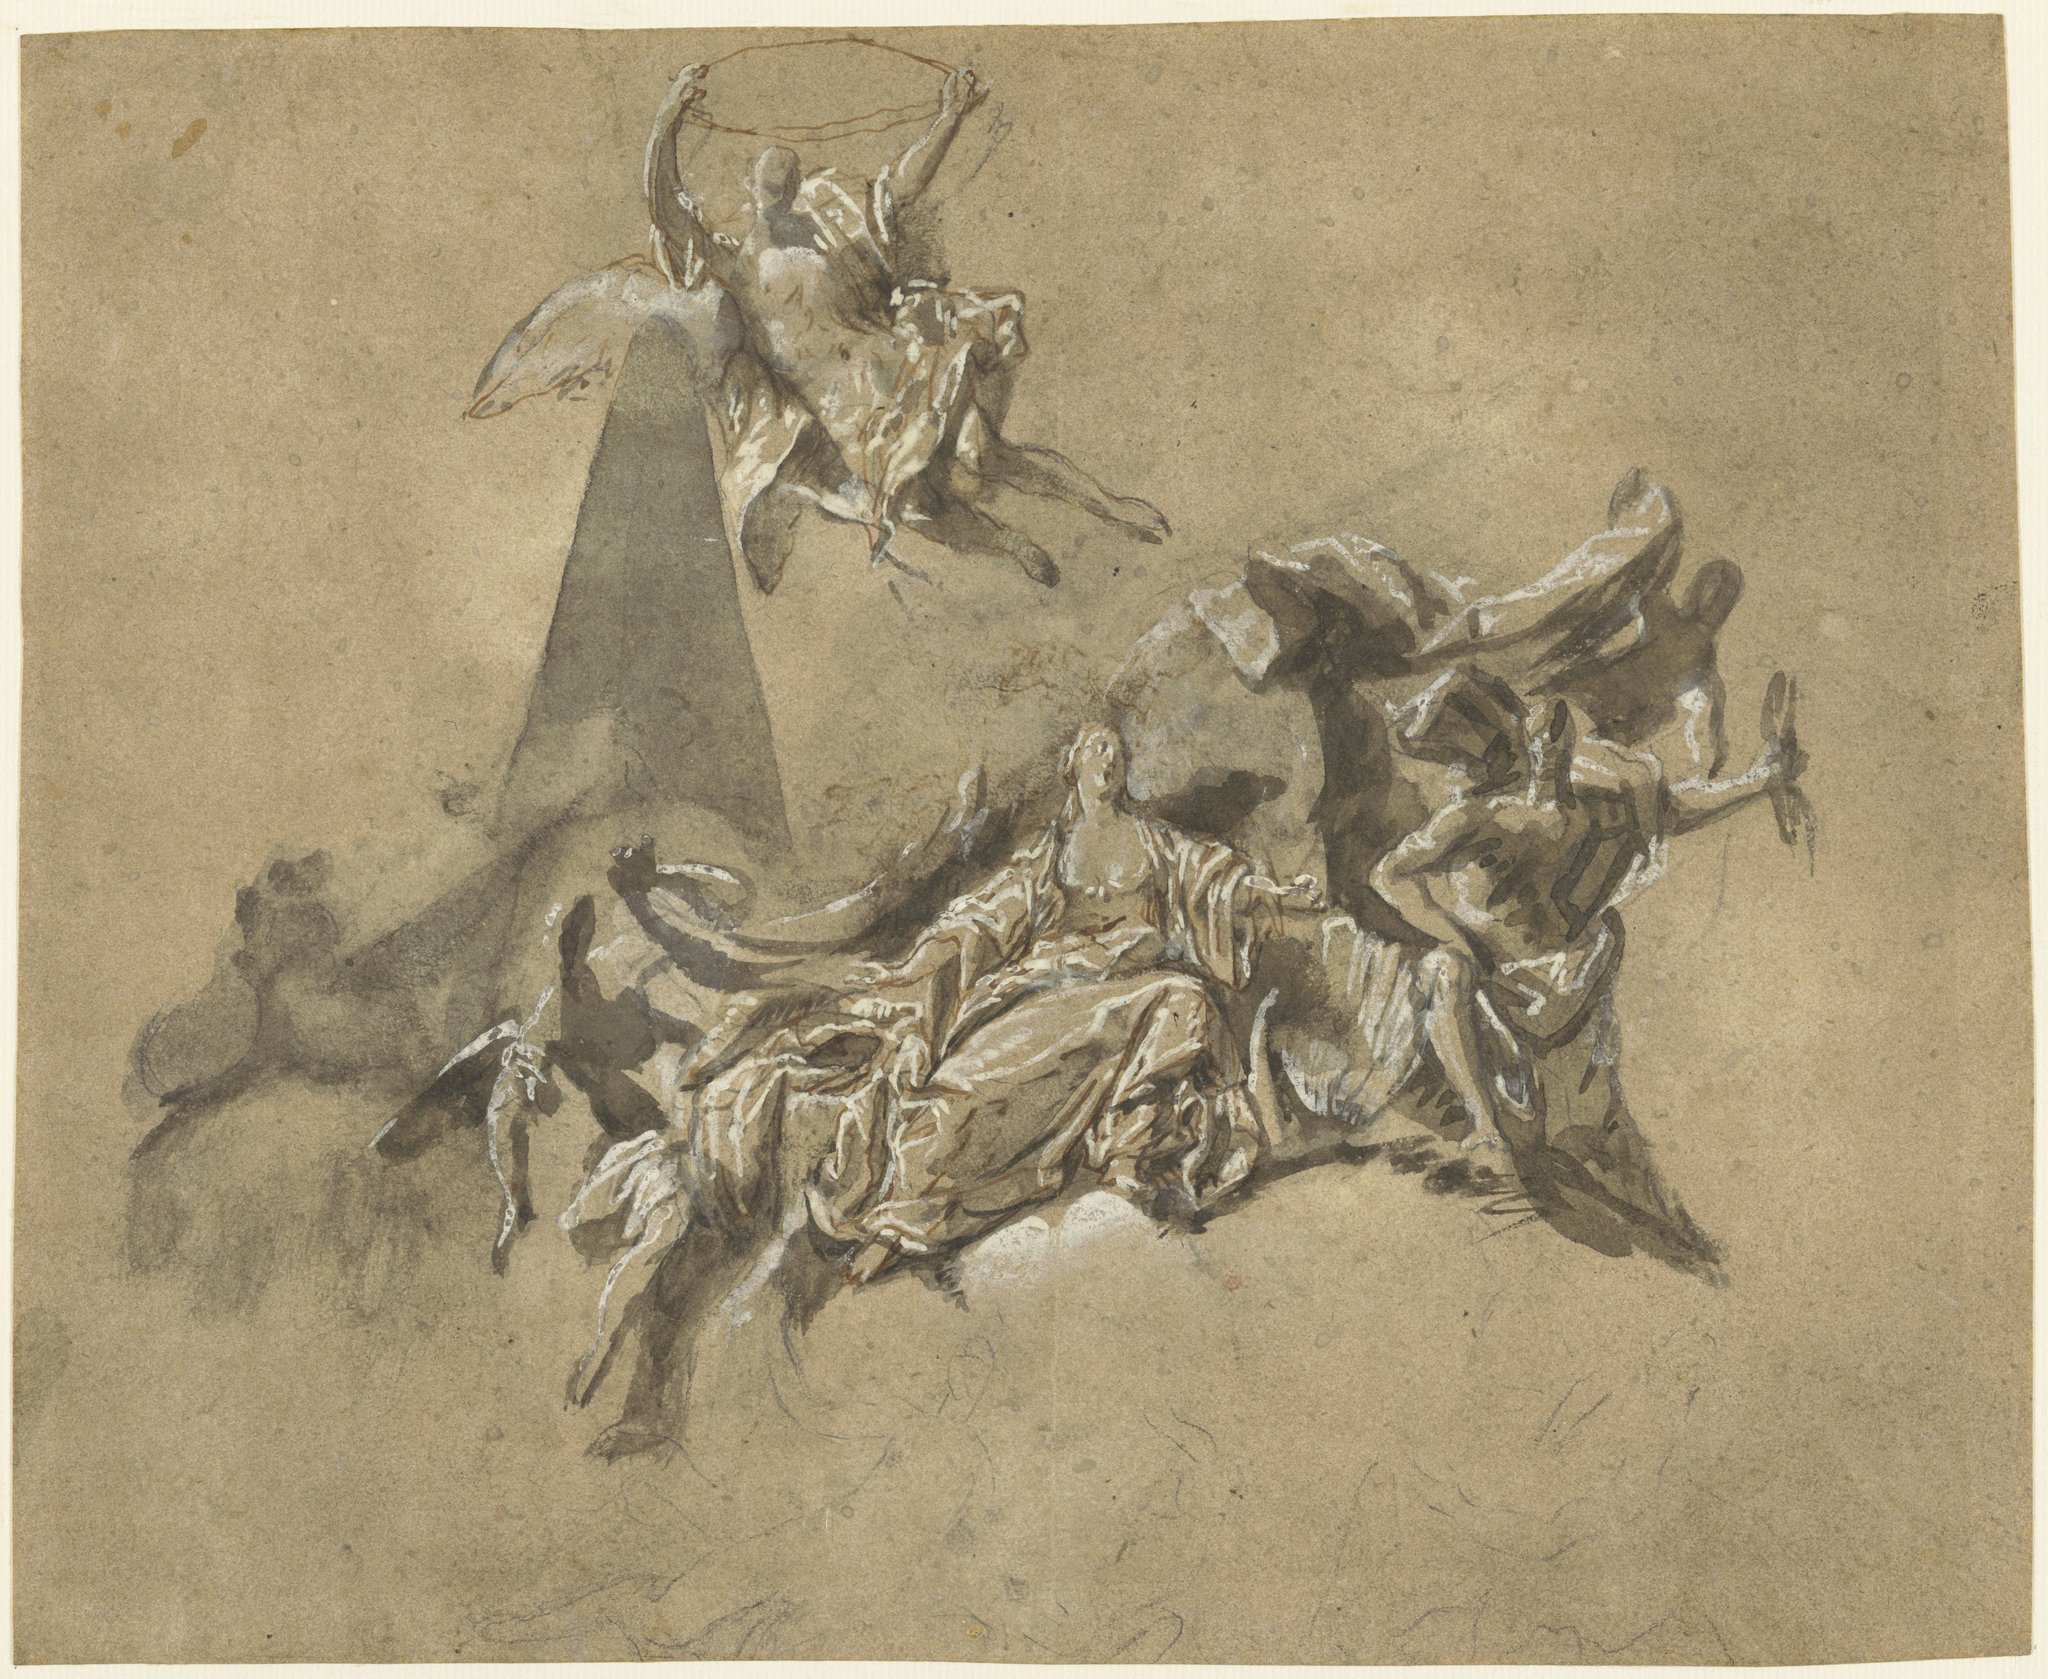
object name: drawing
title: De verheerlijking van Maria Theresia (?)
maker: Anonymous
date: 1700-1800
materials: paper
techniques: brush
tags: vienna, maria theresia (rooms-duits keizerin), apotheosis of a ruler - bb - female ruler